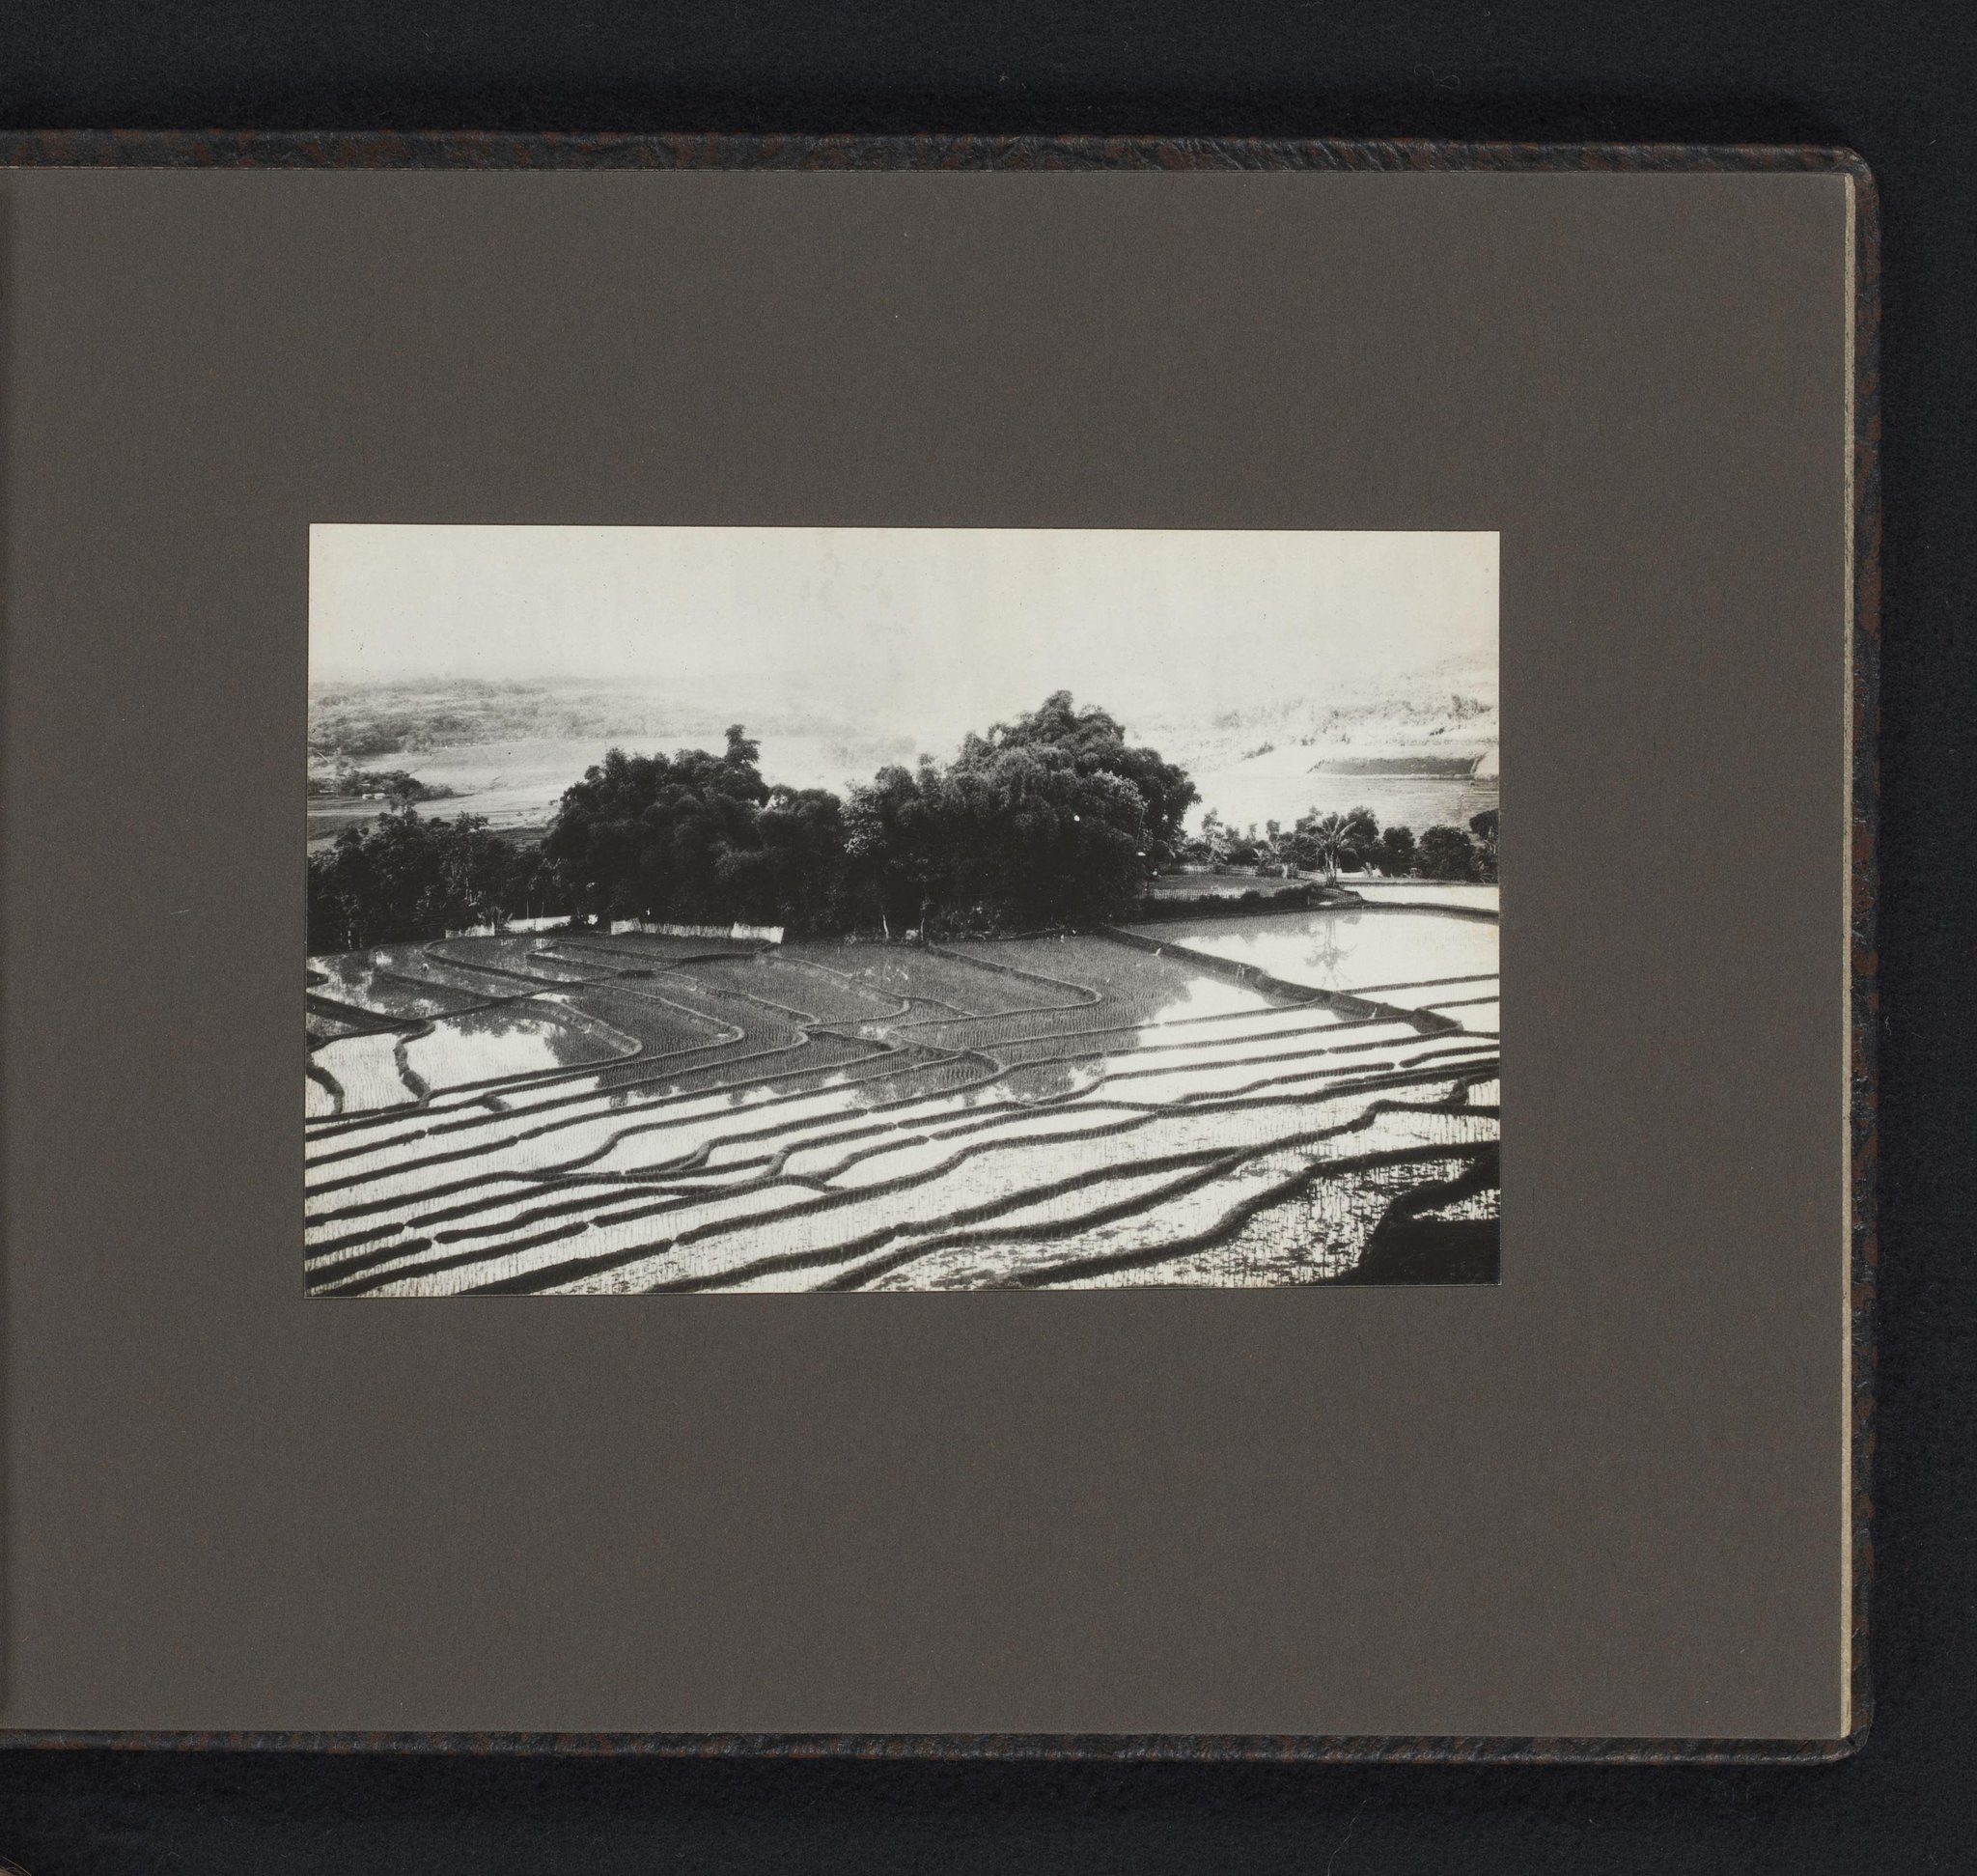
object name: album leaf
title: Gezicht op rijstvelden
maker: adeline andrea. du celliée muller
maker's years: 1899-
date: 1930-1940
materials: paper, photographic support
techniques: gelatin silver print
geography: dutch east indies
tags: trees, sawahs, rice paddies, dutch east indies, the